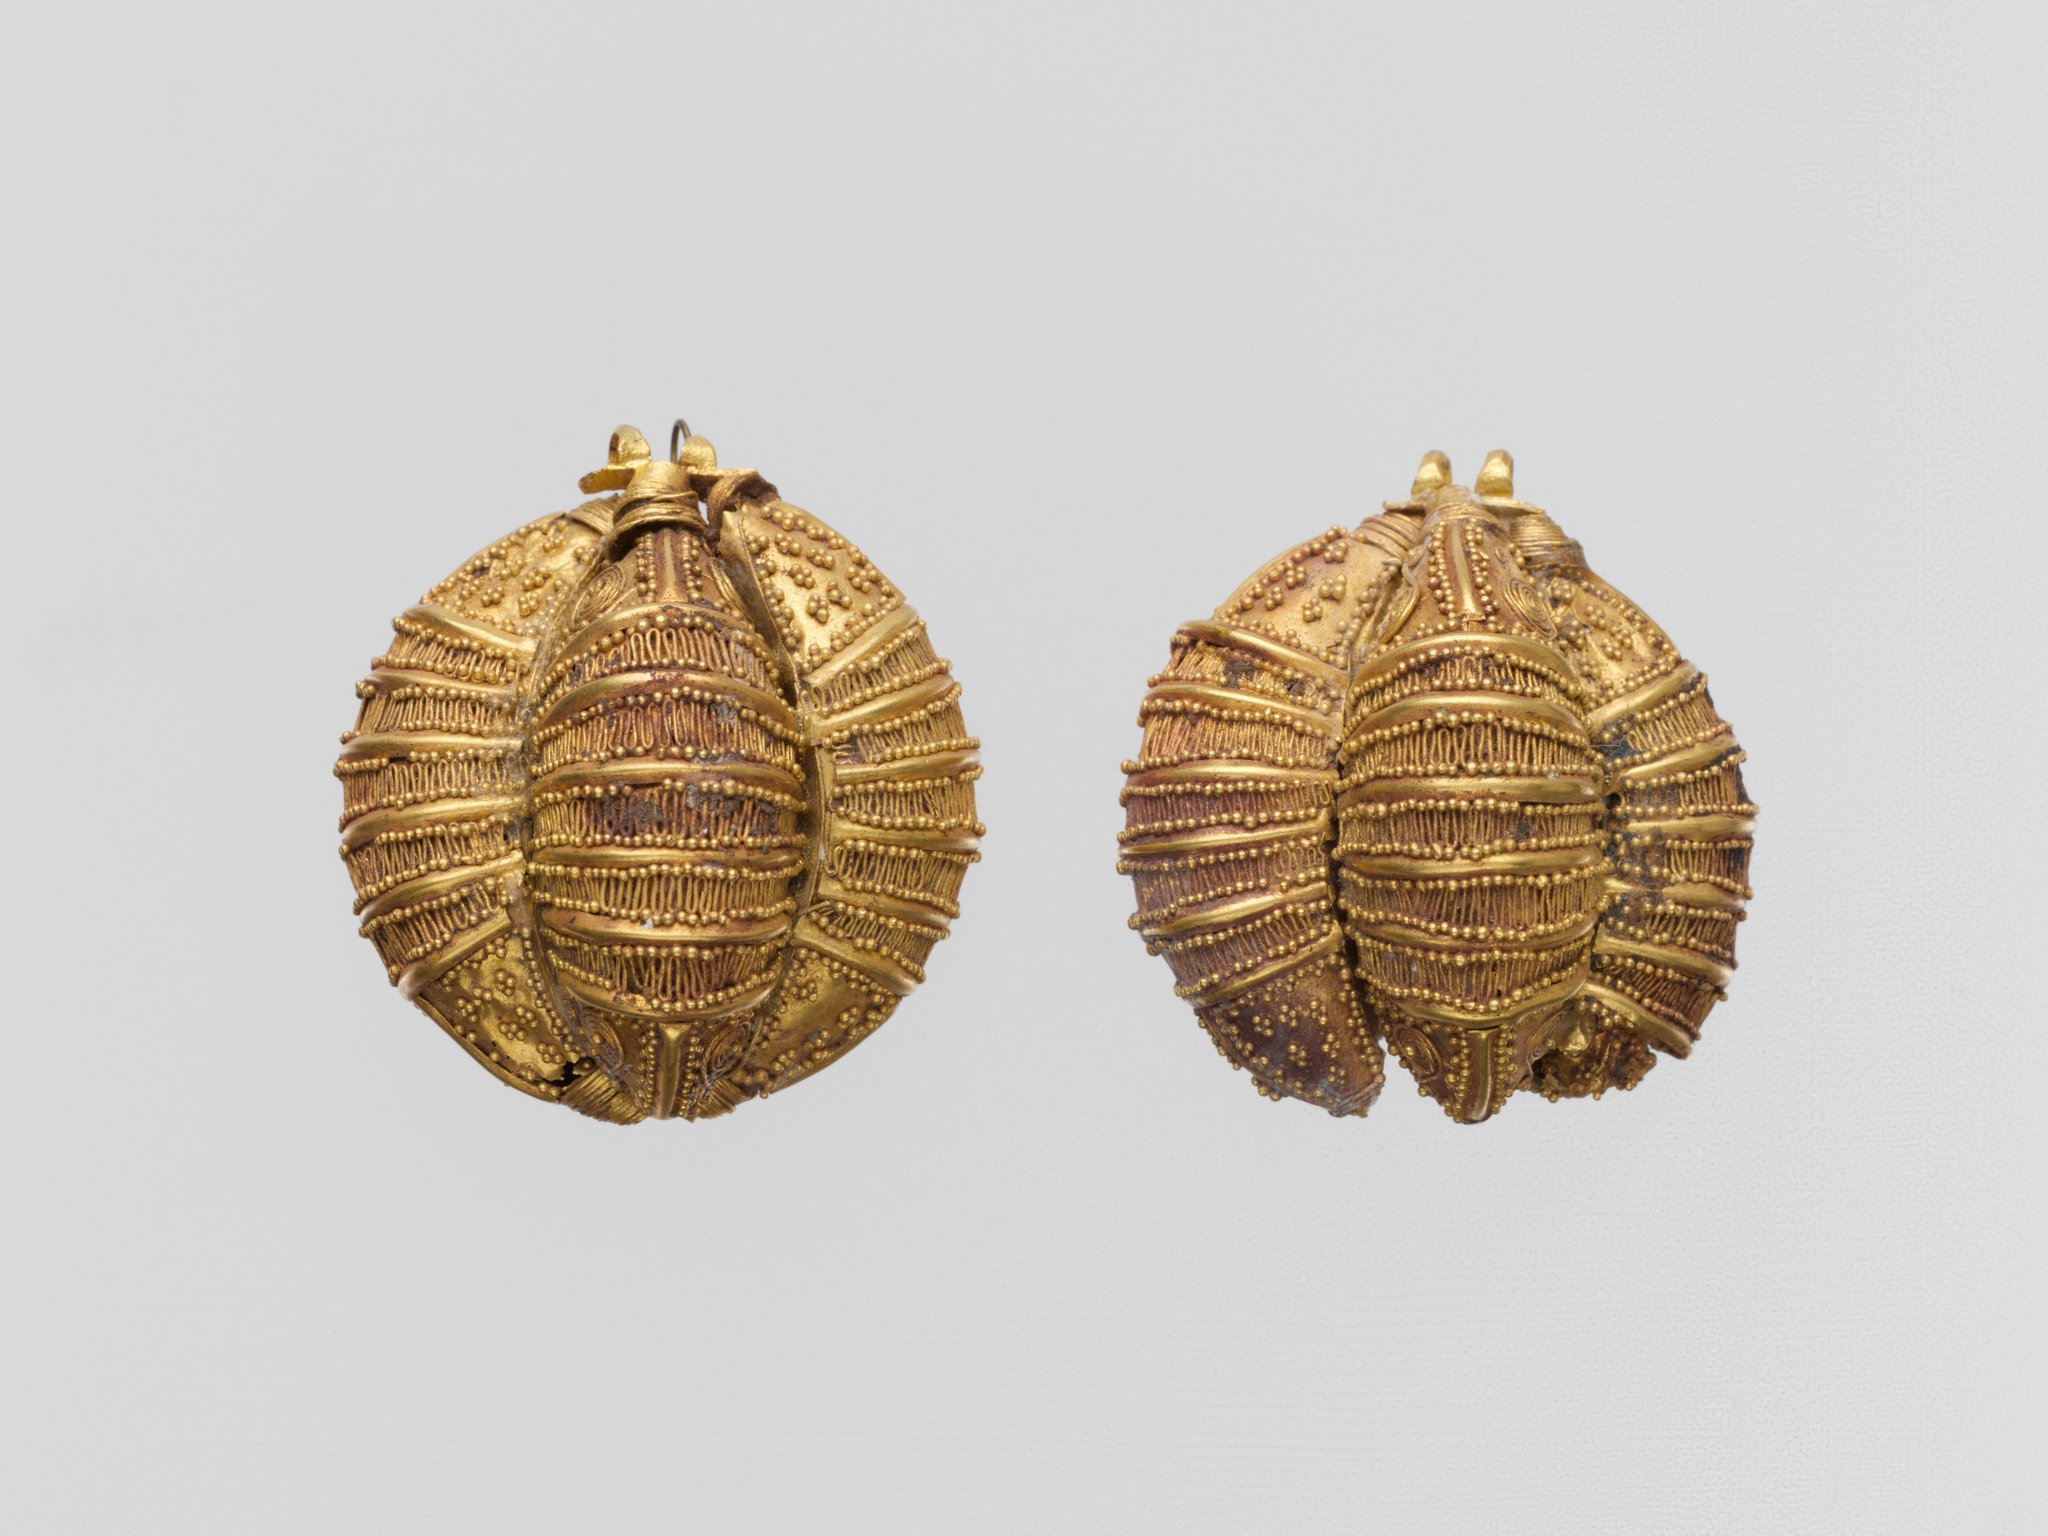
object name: pendant, leech shaped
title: Pair of gold ornaments comprised of three leech-shaped elements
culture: greek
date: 200-1 BCE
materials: gold